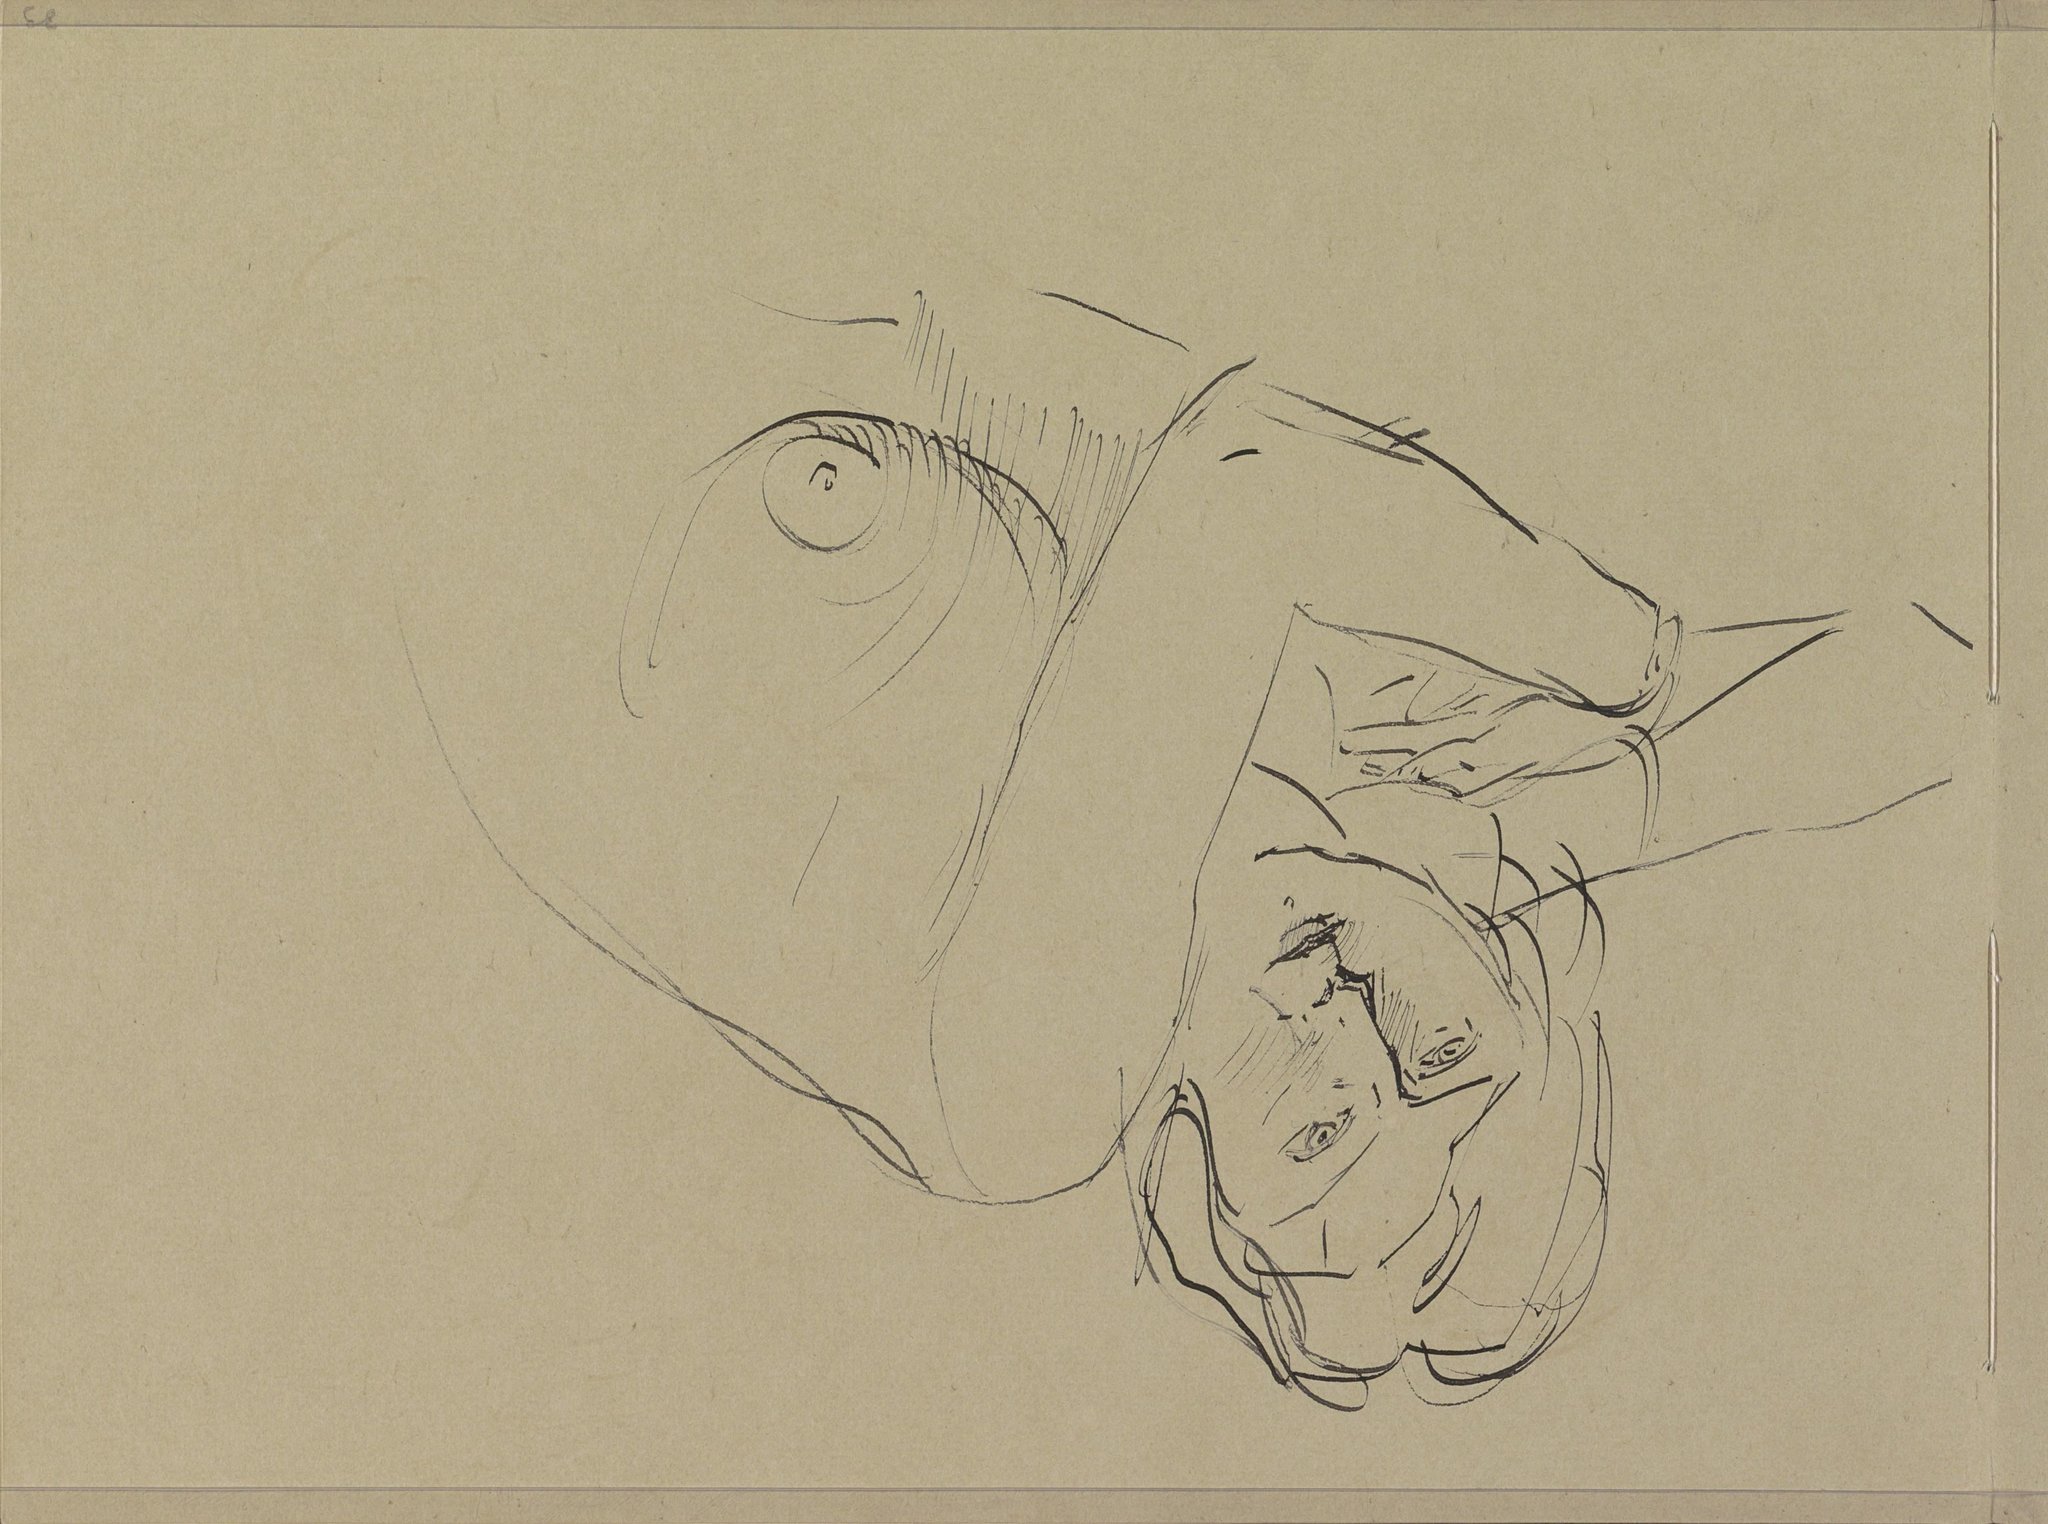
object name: sketchbook leaf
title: Reclining Female Nude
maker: isaac israels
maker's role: draughtsman, painter, print maker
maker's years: 1865-1934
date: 1875-1934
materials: ink, paper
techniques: pen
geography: the hague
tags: lying figure - aa - female human figure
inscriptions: watermark: ‘Holland’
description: Blad 22 verso uit schetsboek IV met 27 bladen.